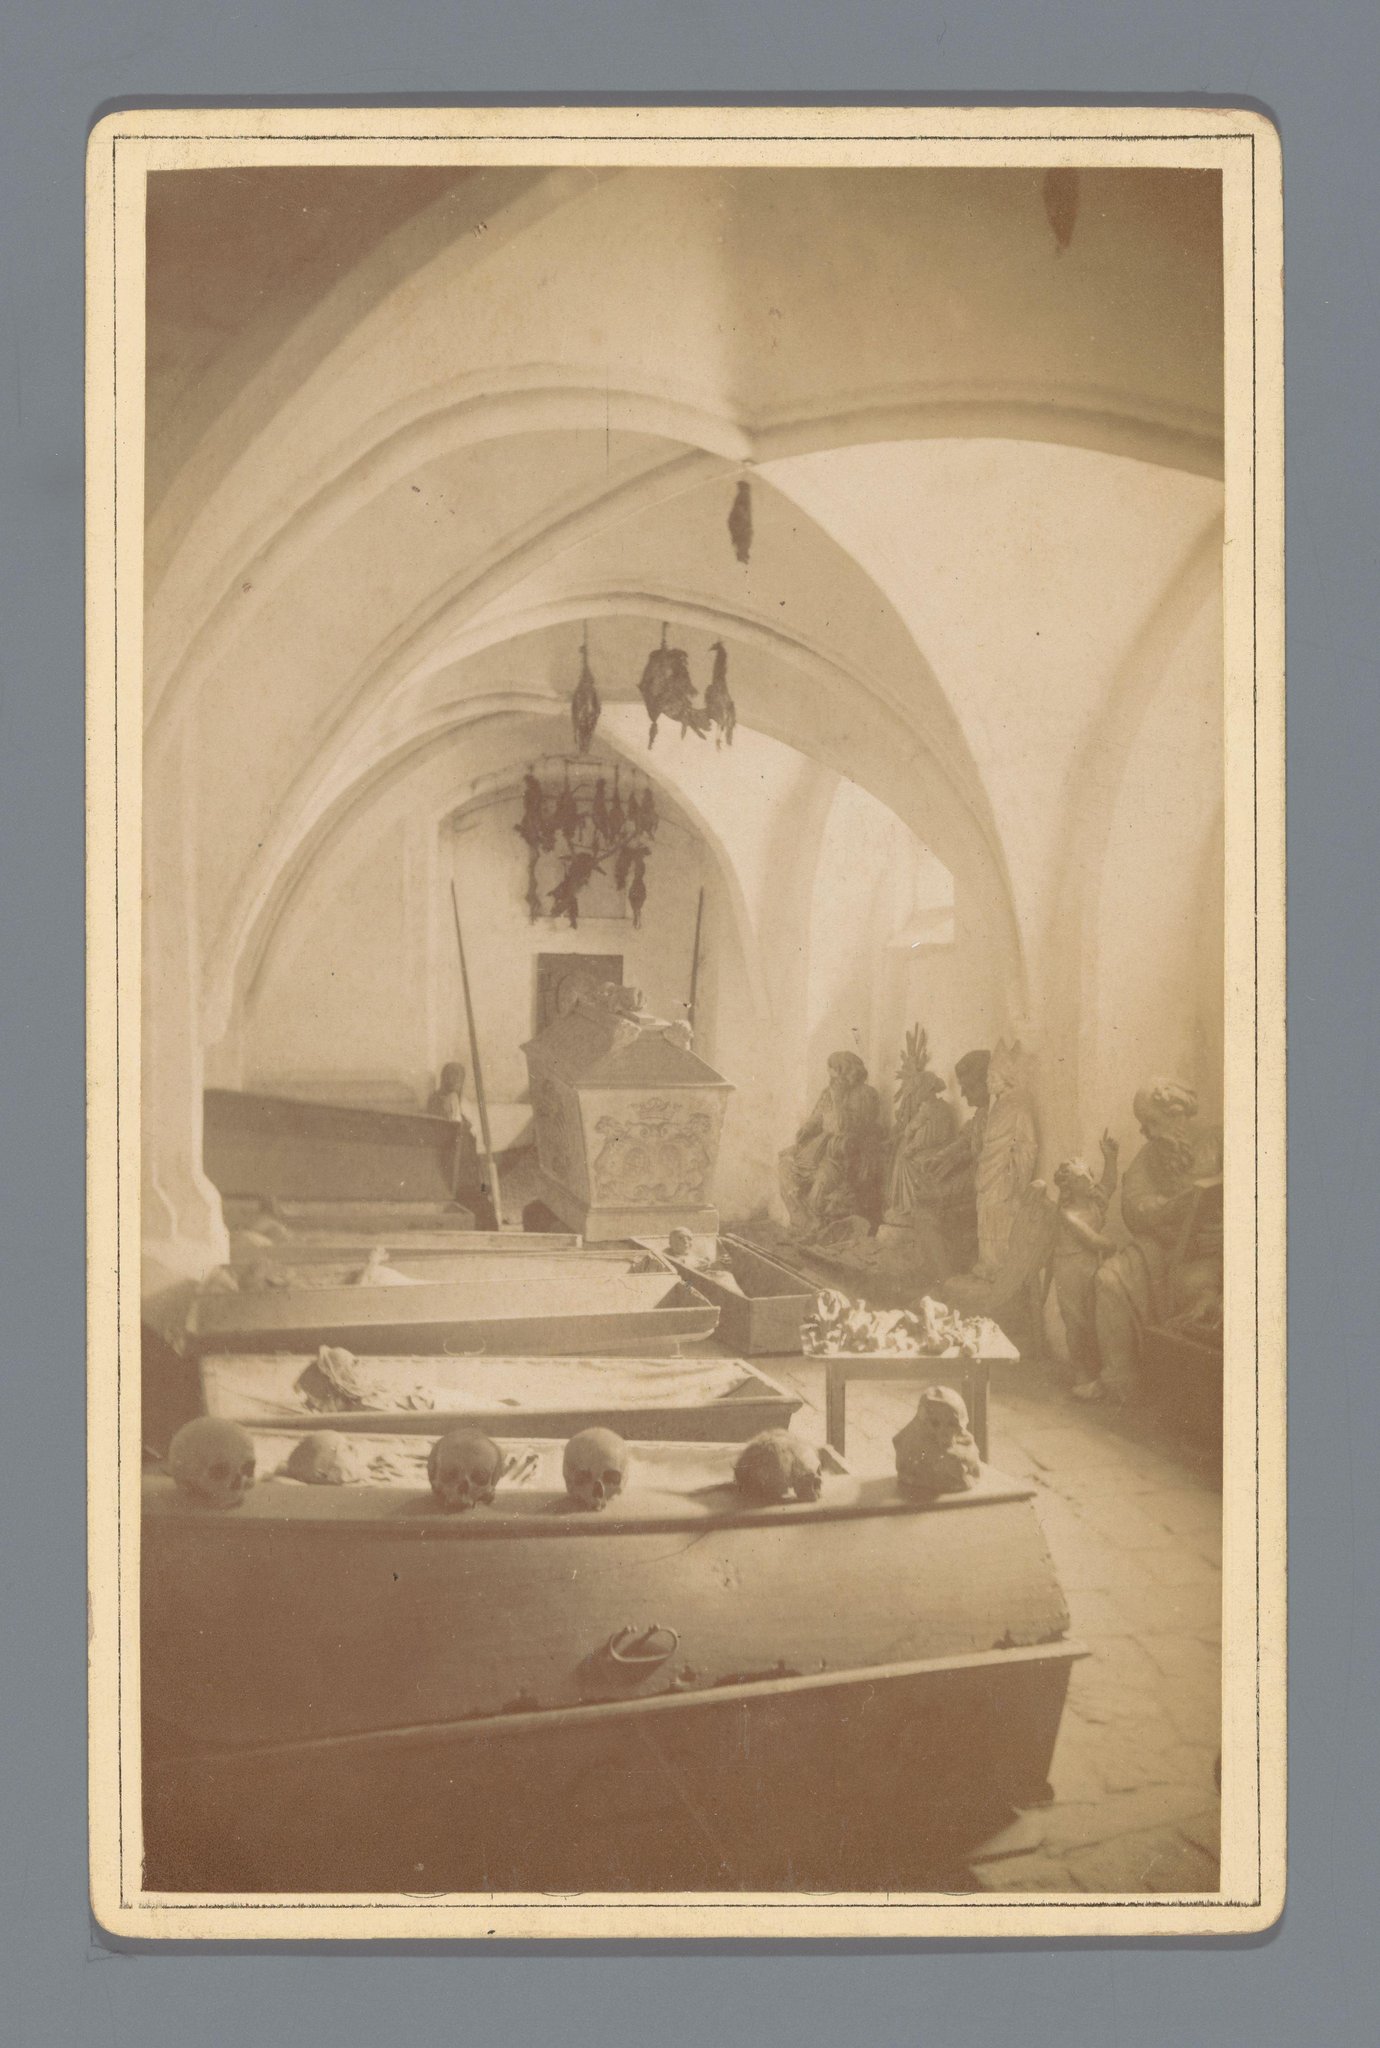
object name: cabinet photograph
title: Grafkelder van de Dom van Bremen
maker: laurentius herzog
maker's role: fotograaf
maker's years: 1831-1913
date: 1850-1868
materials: cardboard, photographic support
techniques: albumen print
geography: bremen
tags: (human) skull, grave, tomb, coffin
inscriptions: inscription: ‘Breme Bleikeller’, inscription: ‘Erster Preis/ Berlin 1865 Hamburg 1868/ L. Herzog Atelier für Photographie Bremen,/ Wall 160./ Die Platte bleibt reservirt.’